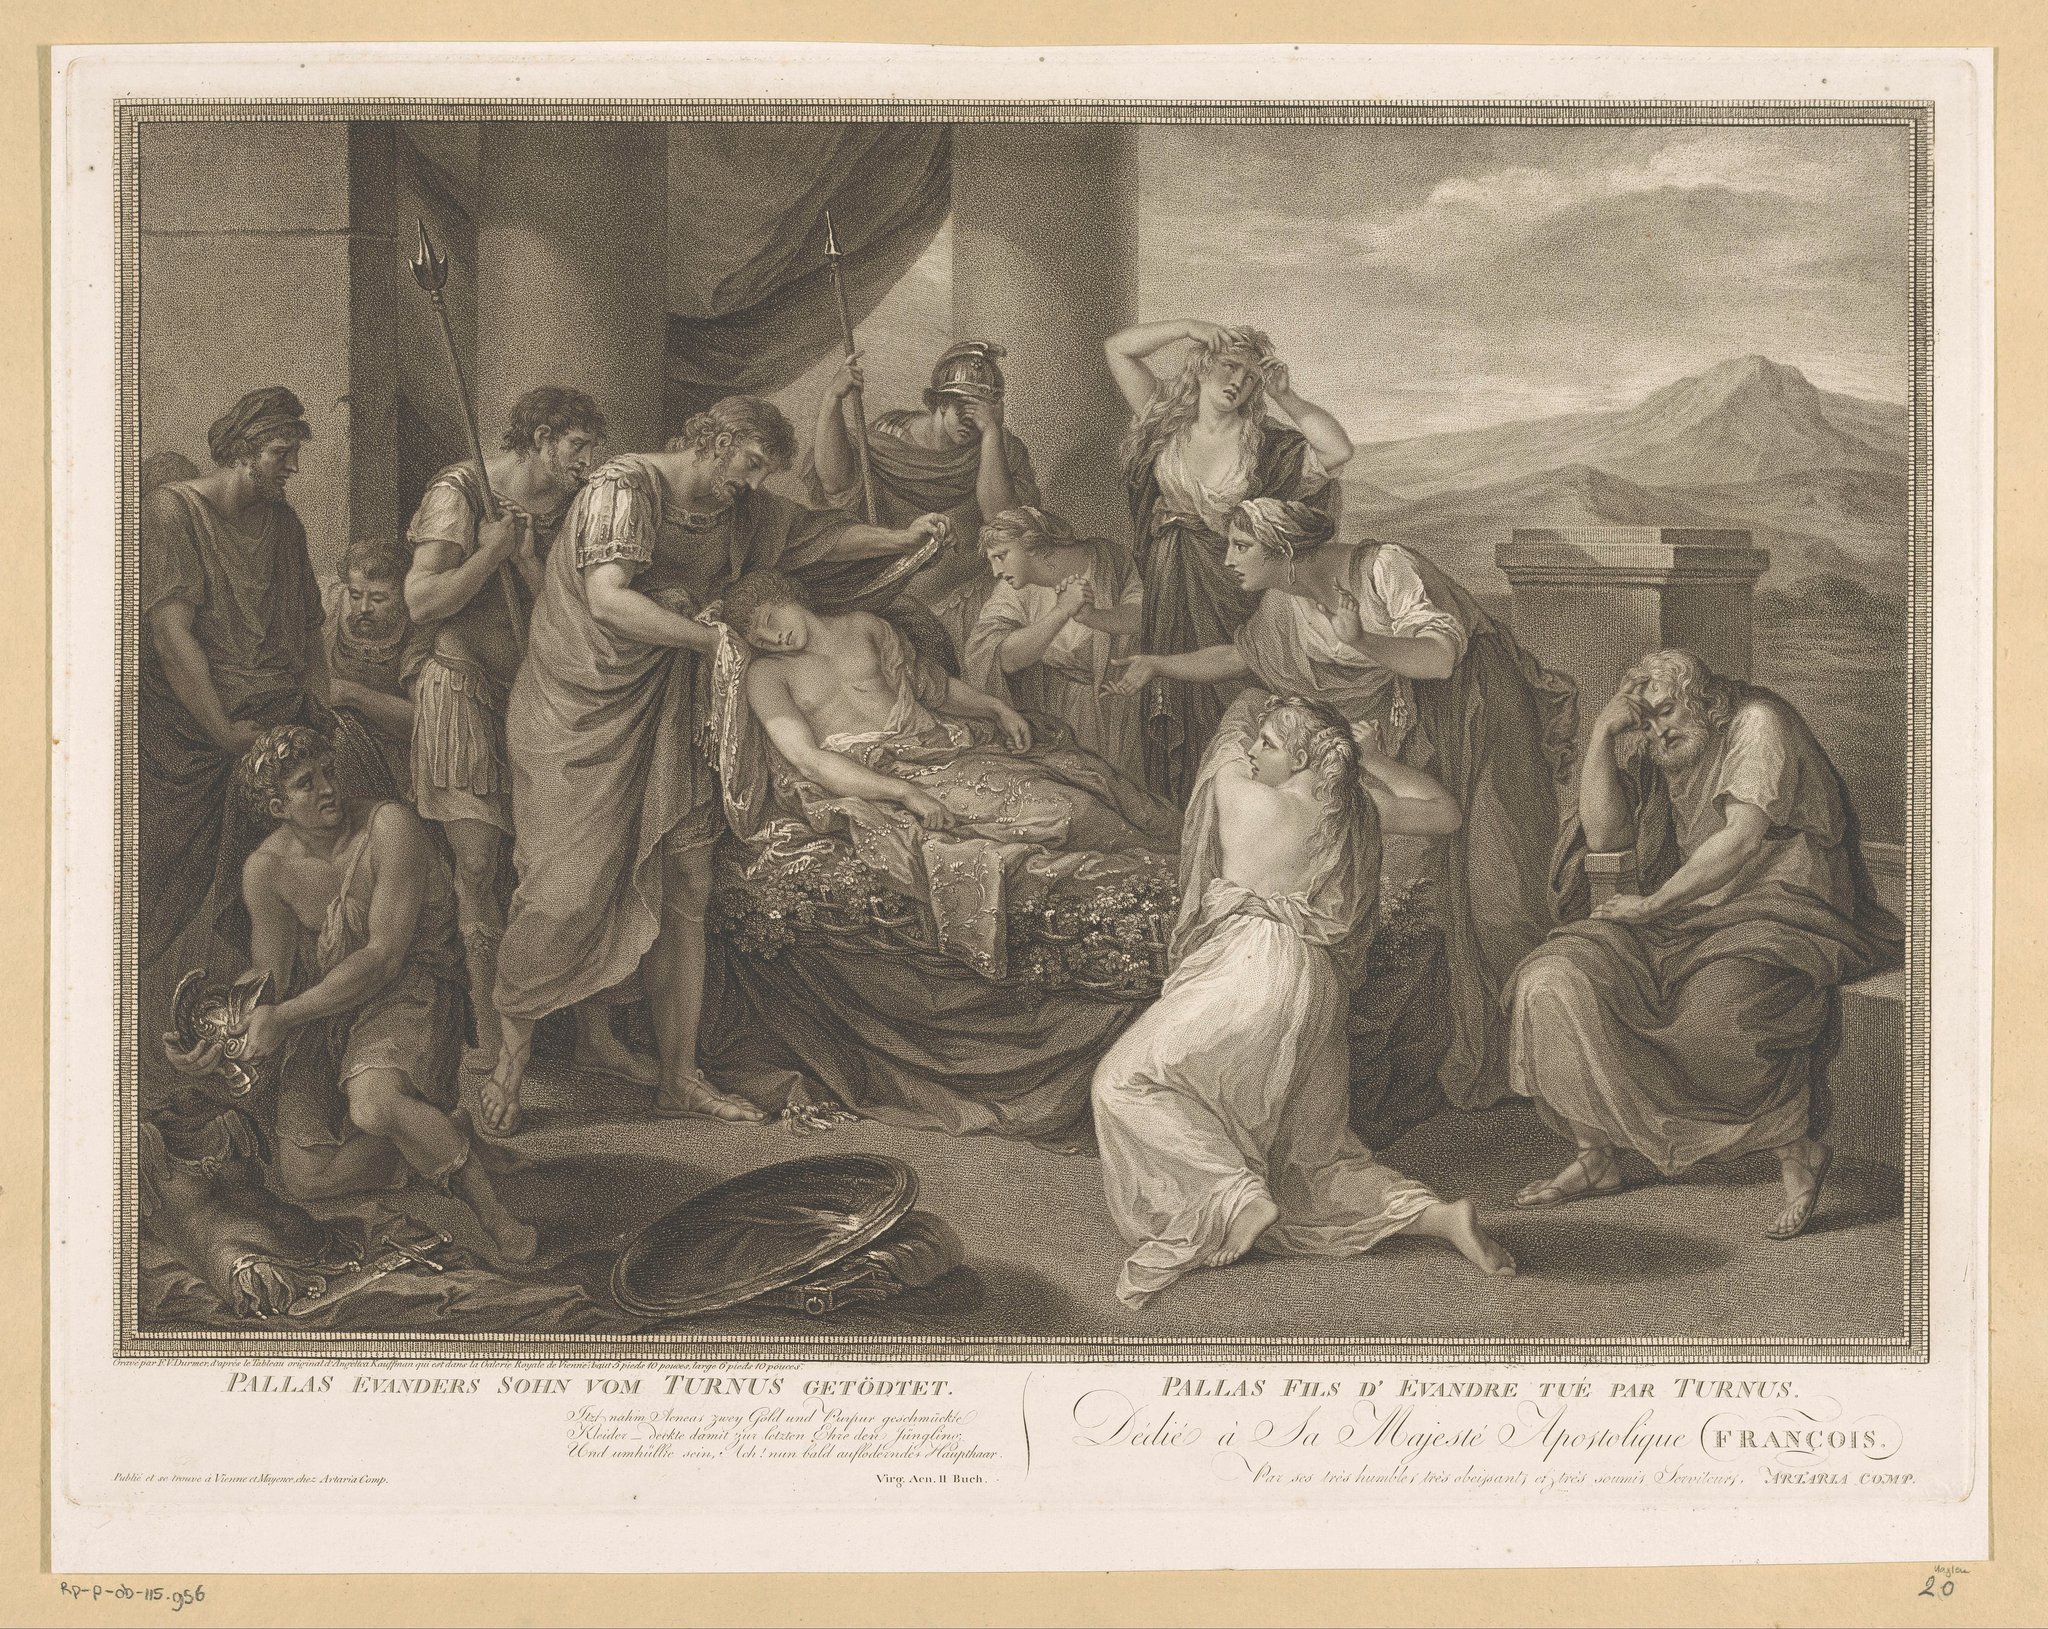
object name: print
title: Pallas Evanders sohn vom Turnus getötet / Pallas fils d'Evandre tué par Turnus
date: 1776-1835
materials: paper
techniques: stippling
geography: vienna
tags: pallas is killed by turnus